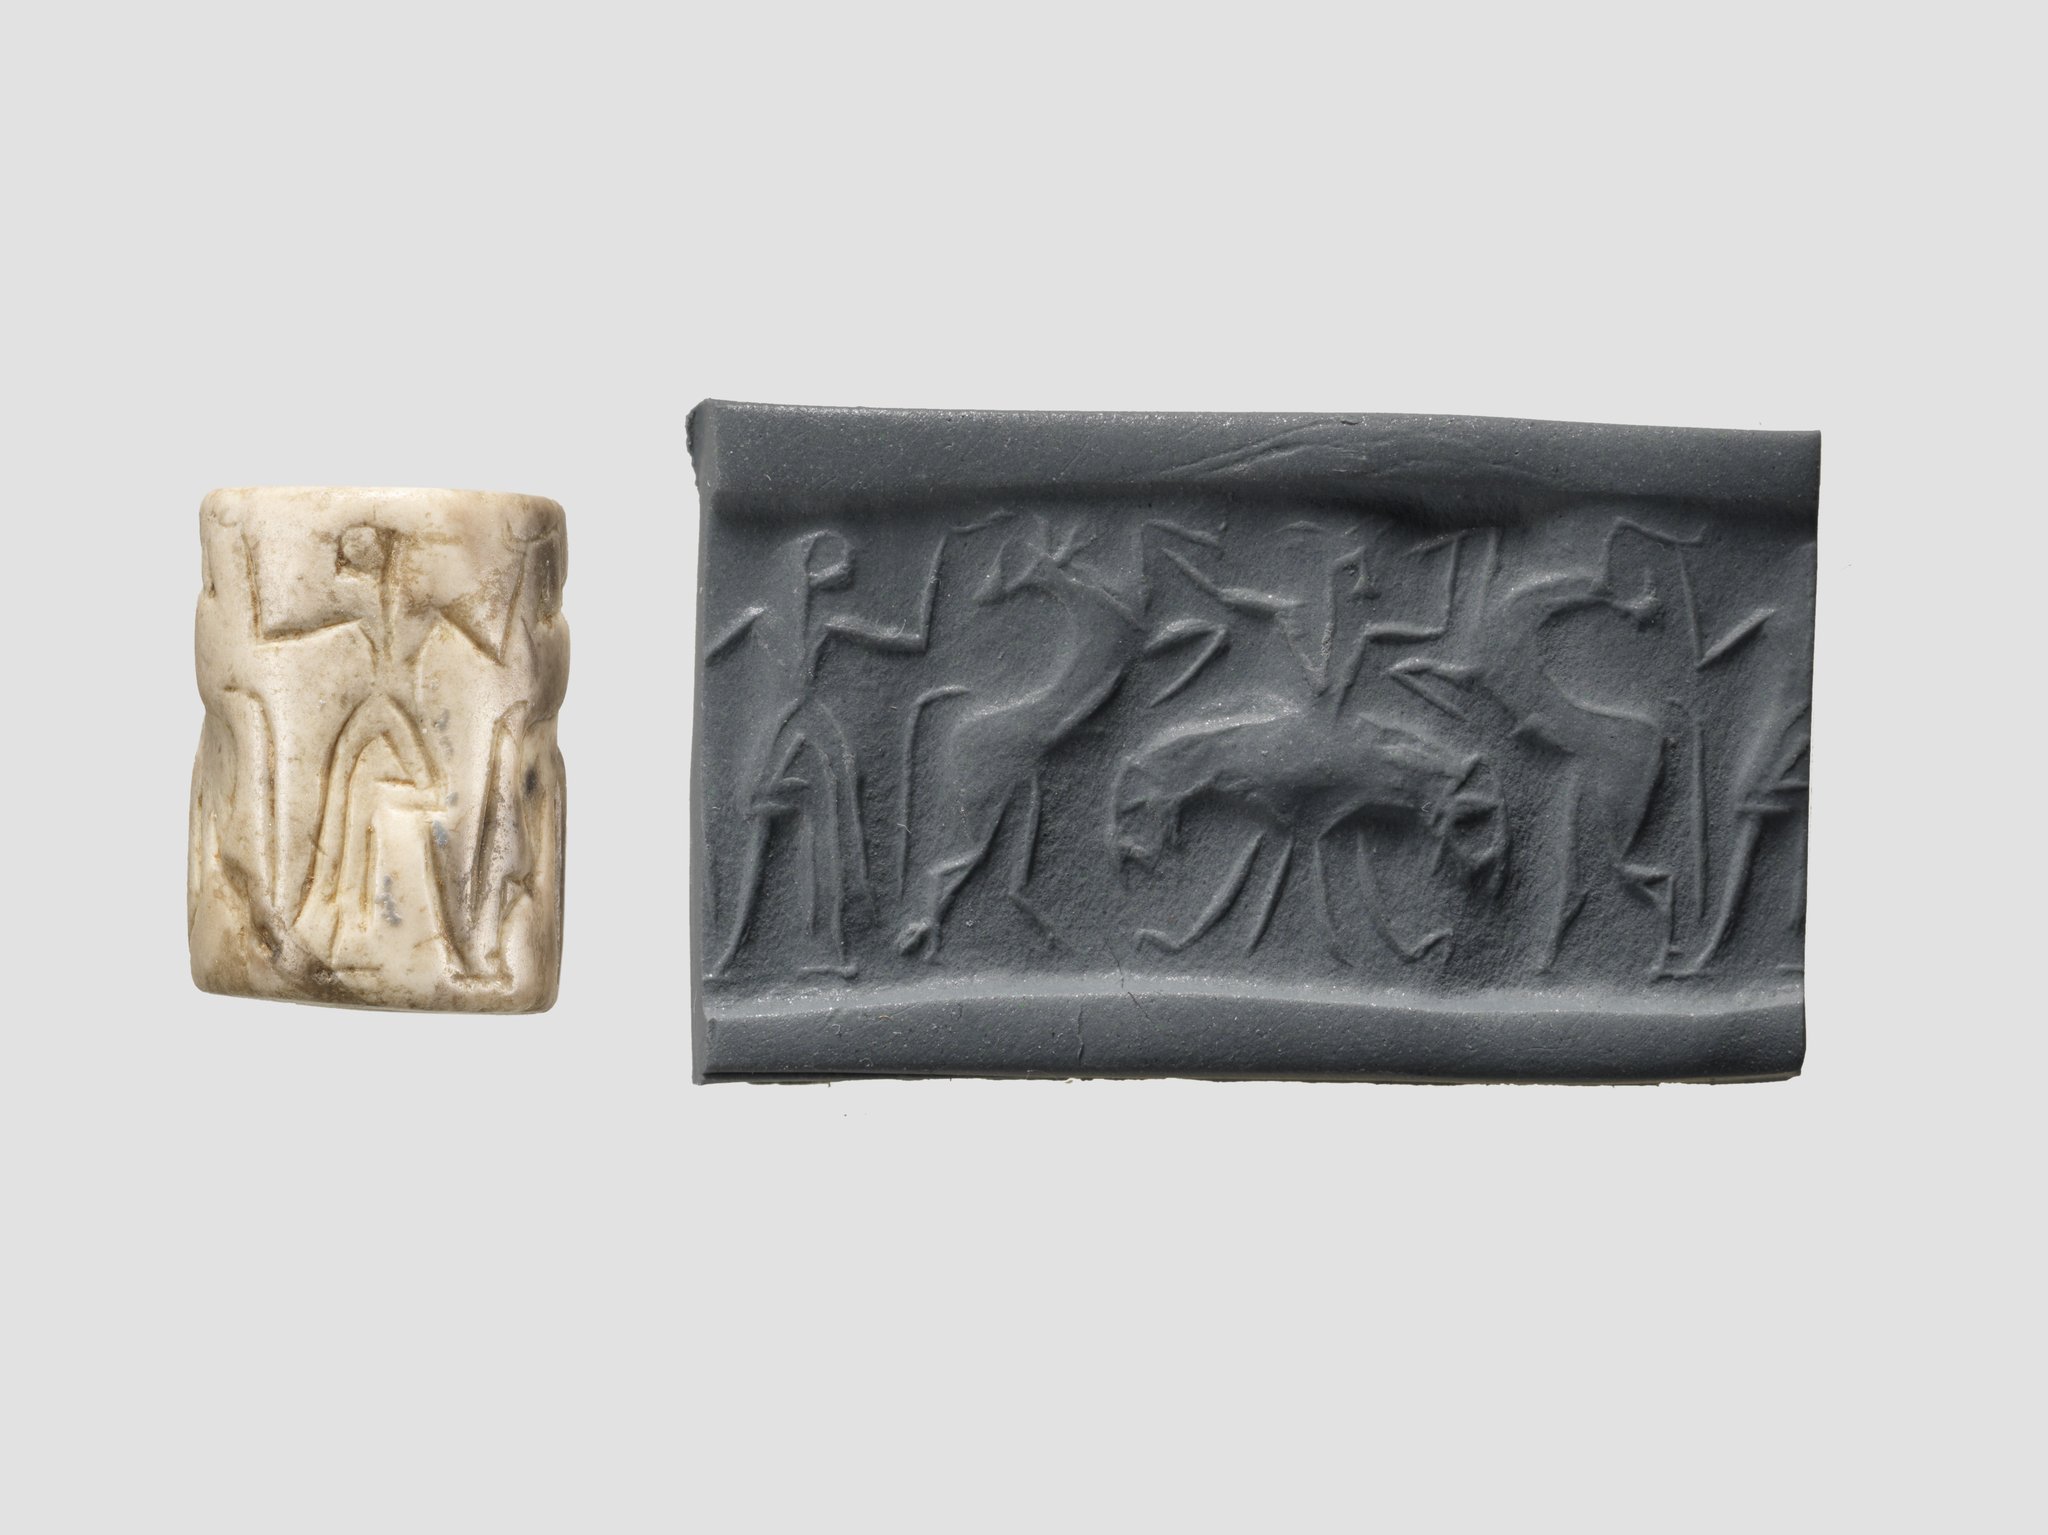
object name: cylinder seal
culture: sumerian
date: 2700-2600 BCE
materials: stone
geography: mesopotamia